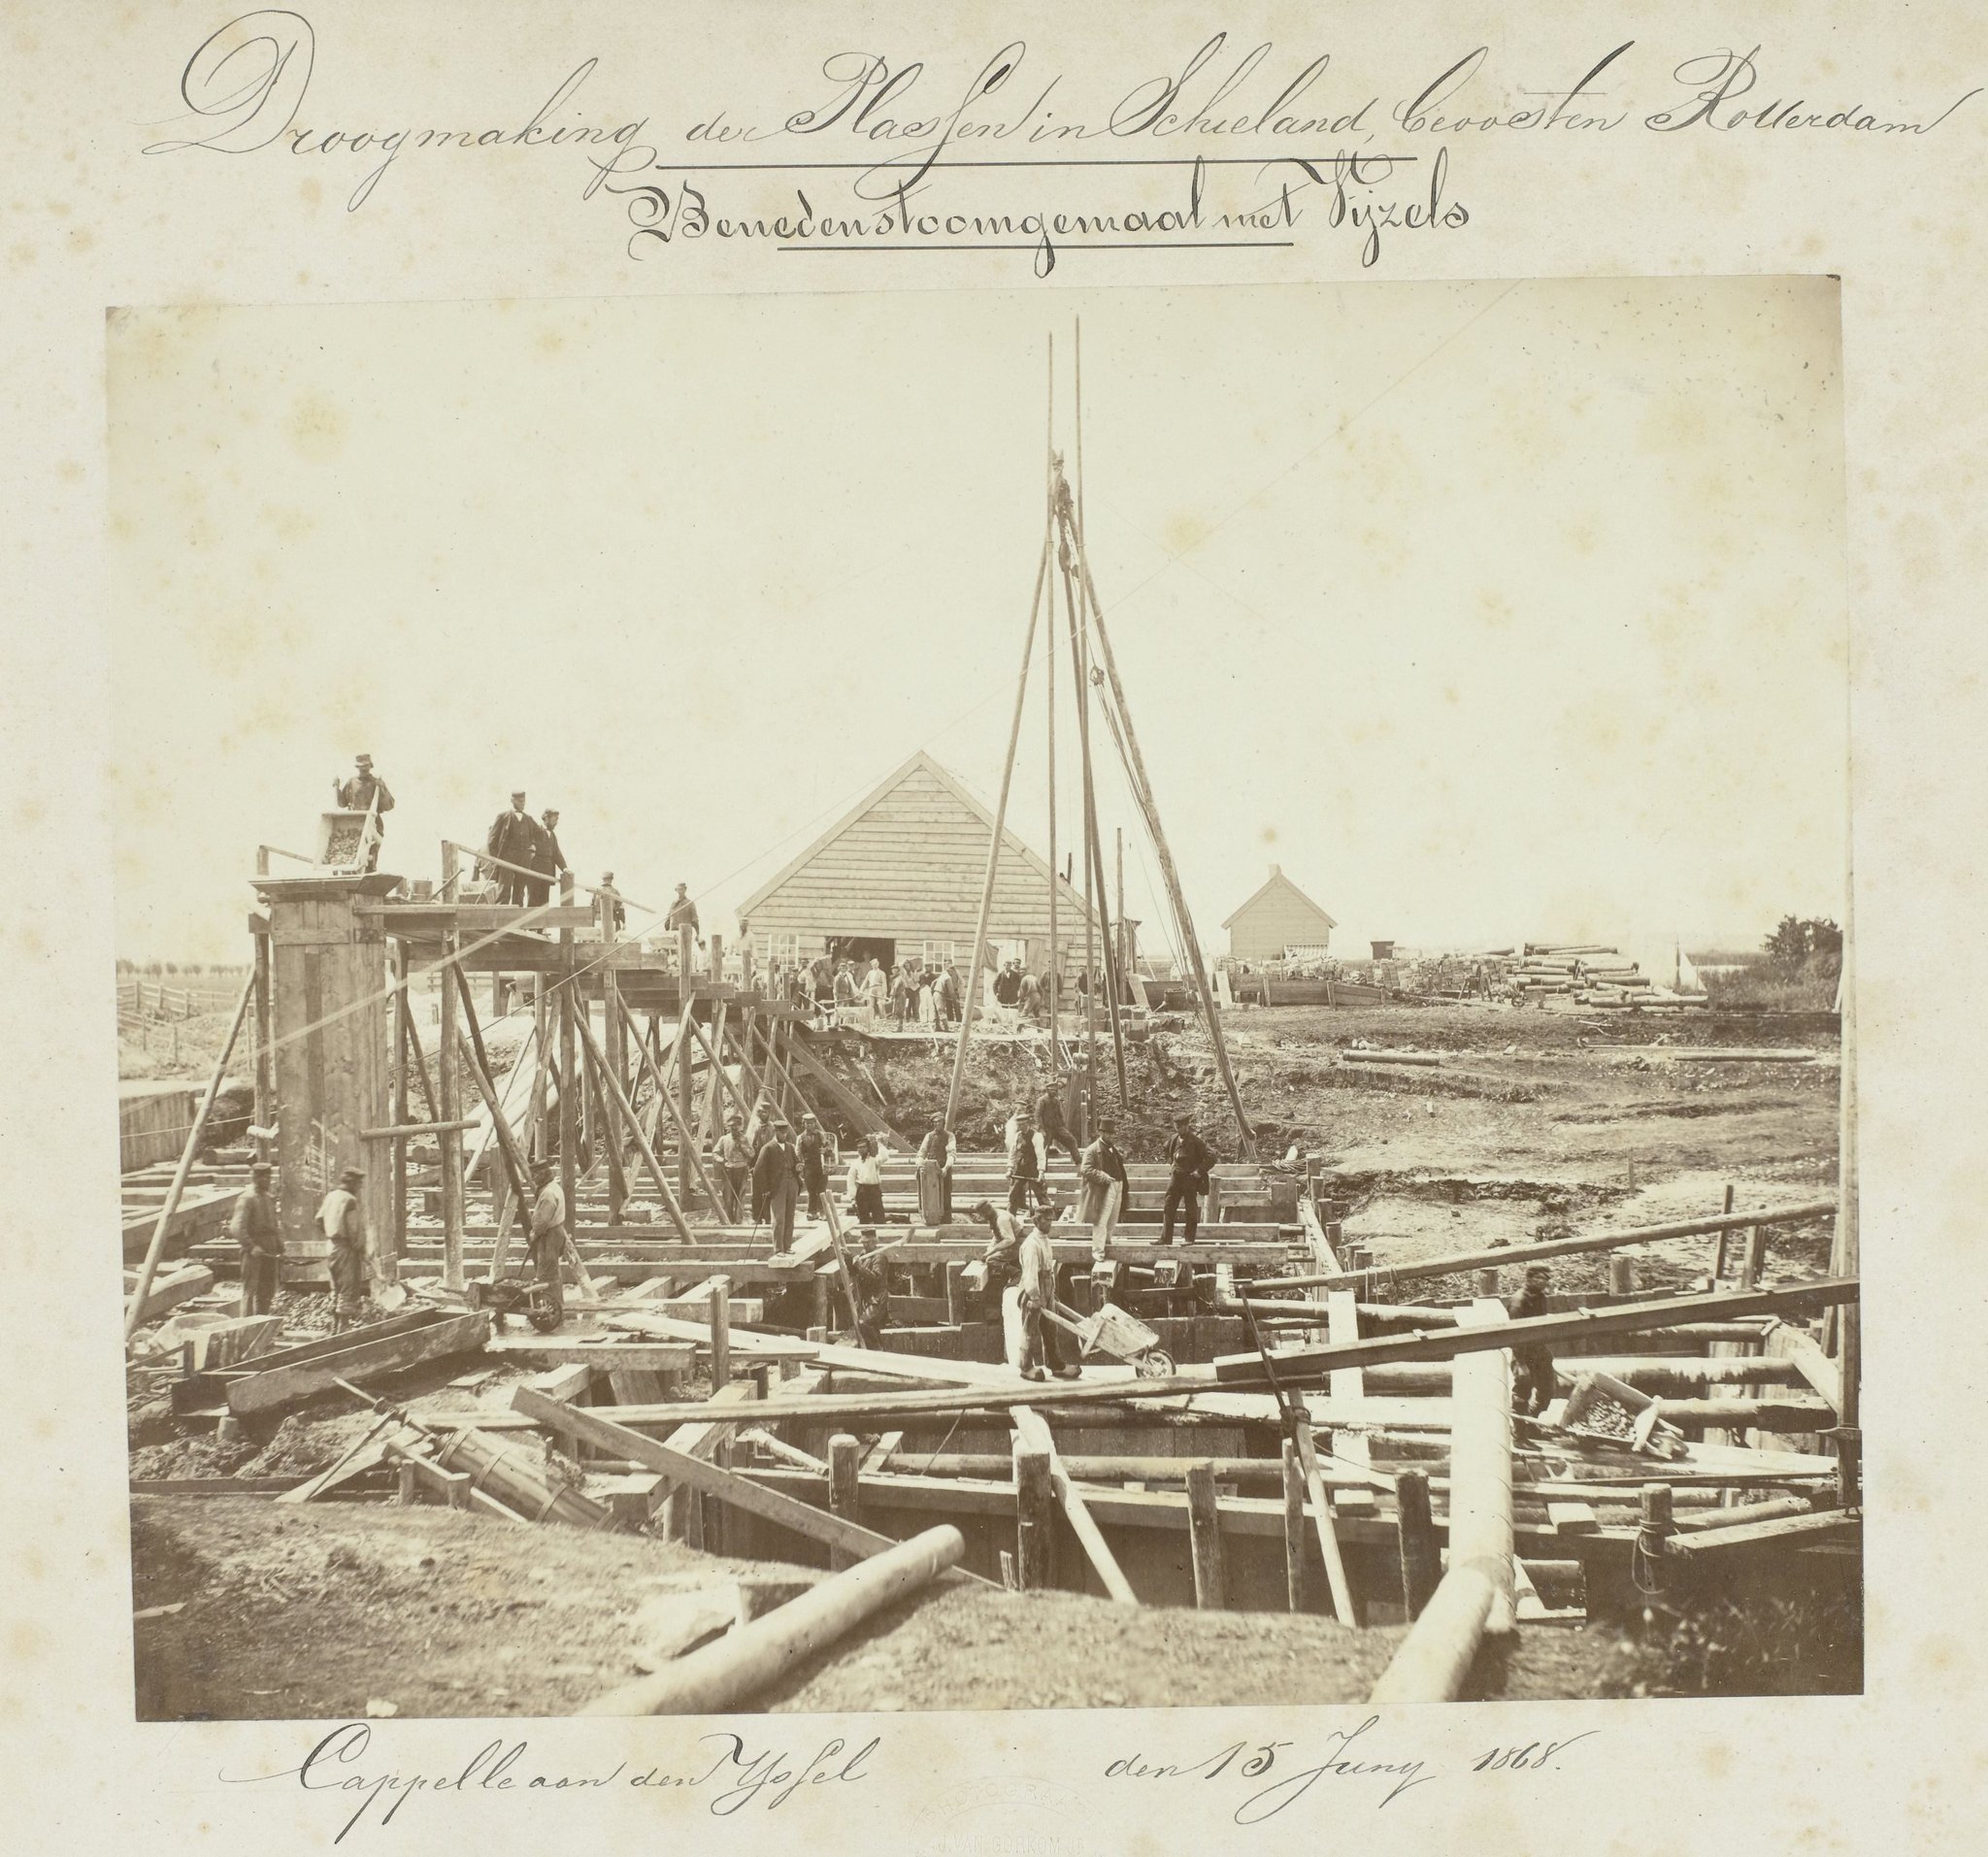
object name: photograph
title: Droogmaking der Plassen in Schieland, beoosten Rotterdam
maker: jacobus van gorkom (jr.)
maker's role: print maker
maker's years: 1827-1880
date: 1868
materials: cardboard, paper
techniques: photography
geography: rotterdam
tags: rotterdam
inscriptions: date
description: Foto op karton van een droogmaking (plassen bij Rotterdam); gedateerd, met opschrift in pen: Cappelle a/d IJssel.